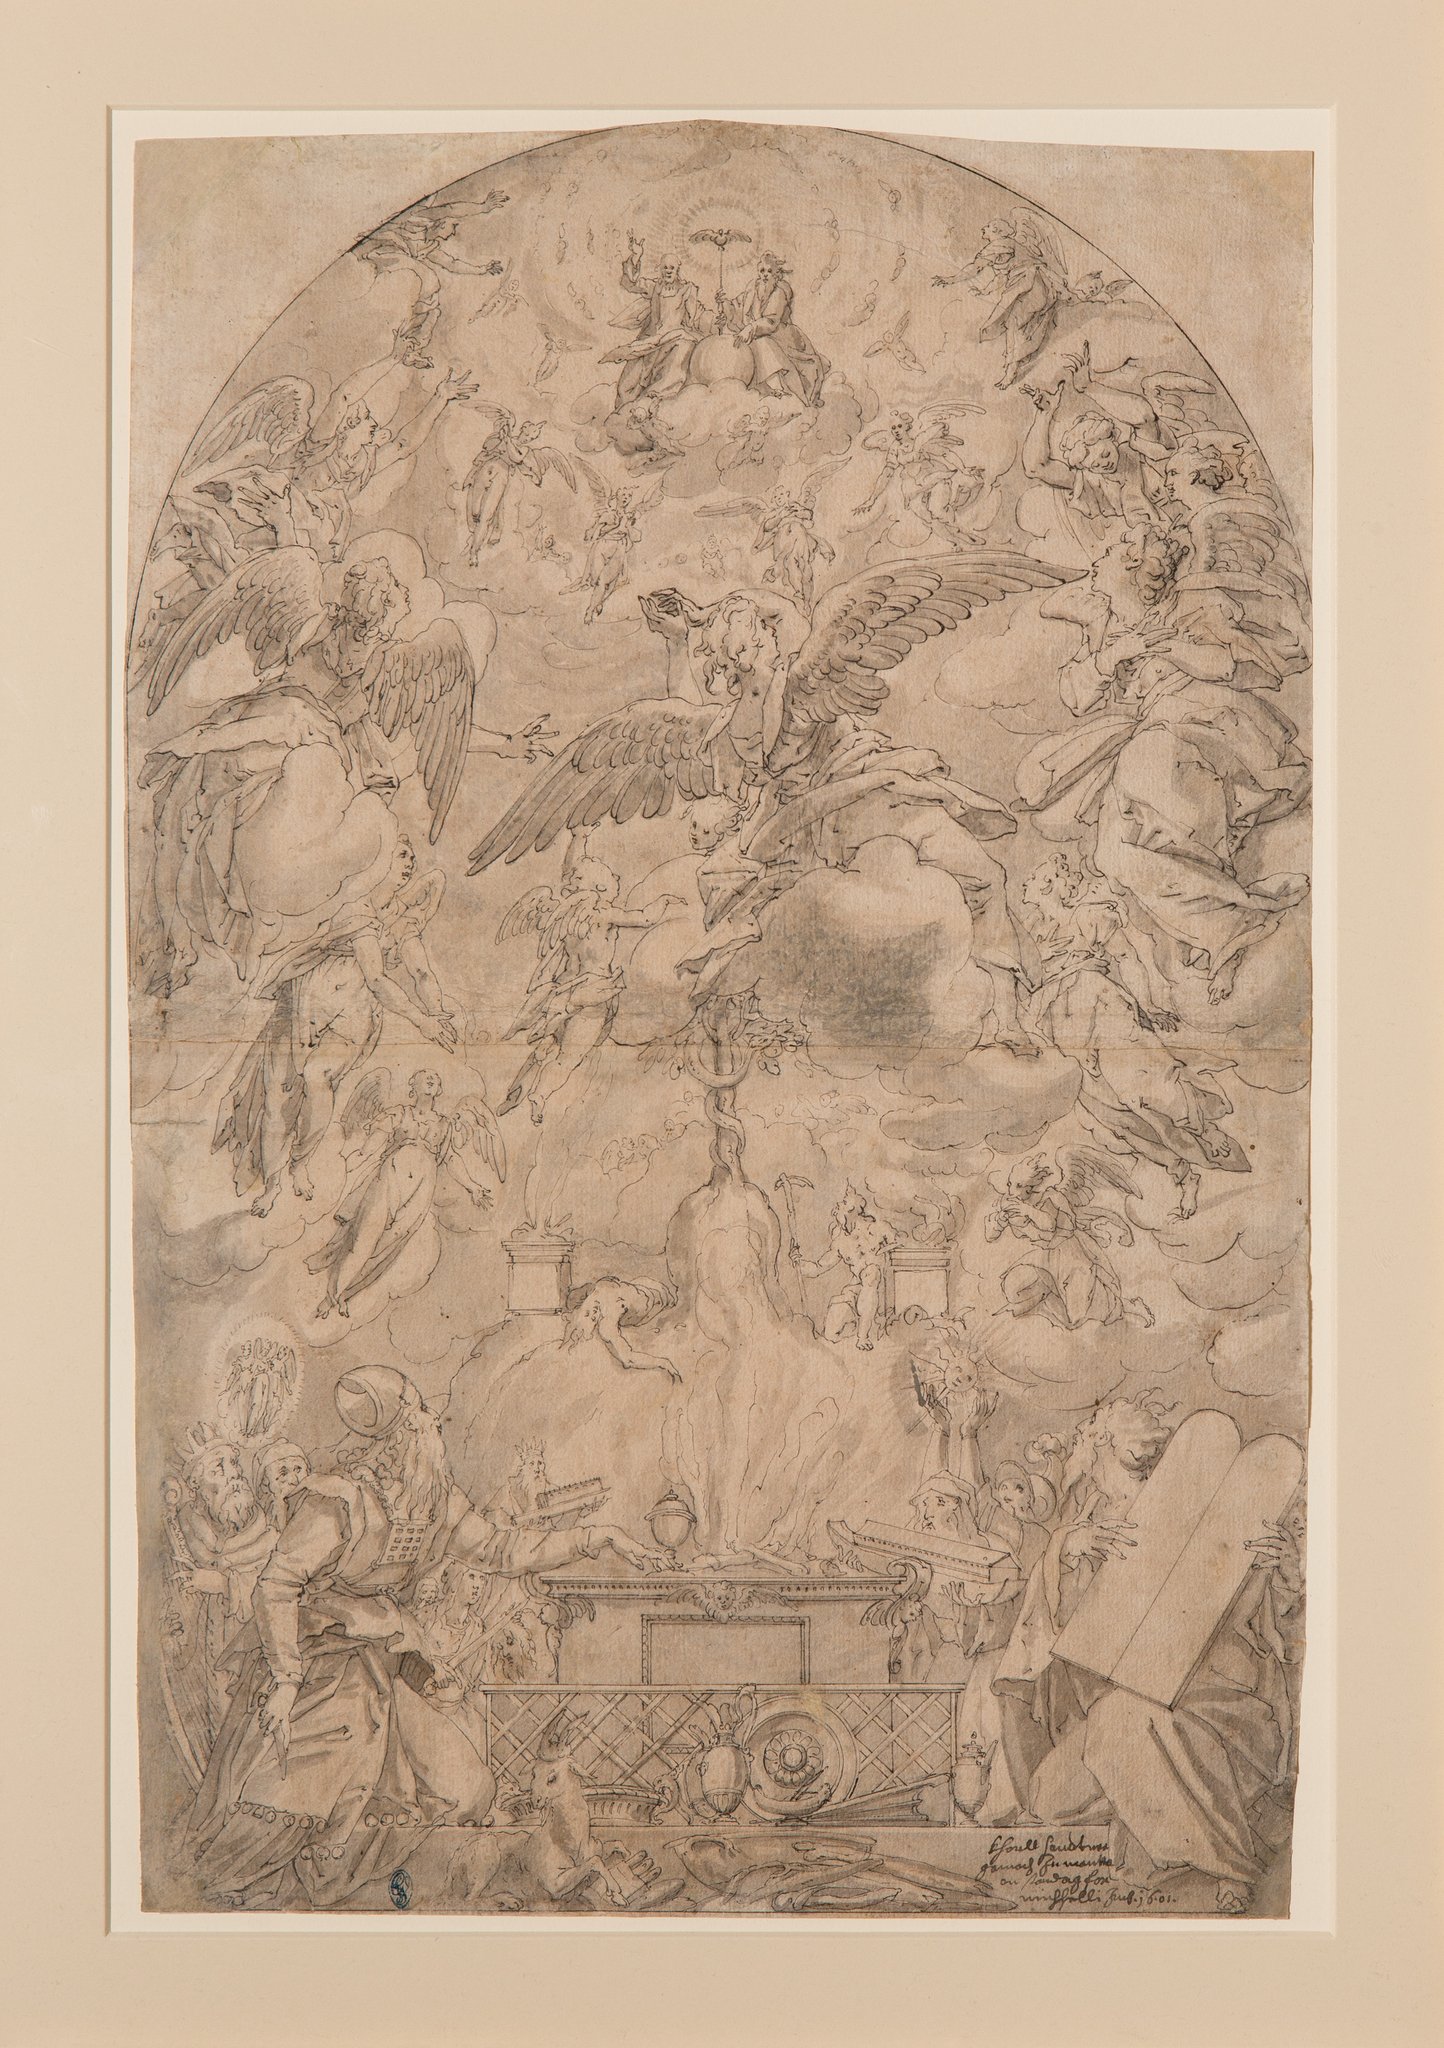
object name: drawing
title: The Adoration of the Holy Trinity in the Old Covenant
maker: karl sandtner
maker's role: artist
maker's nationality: german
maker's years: 1550-1650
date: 1601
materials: ink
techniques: brush, pen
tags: angels